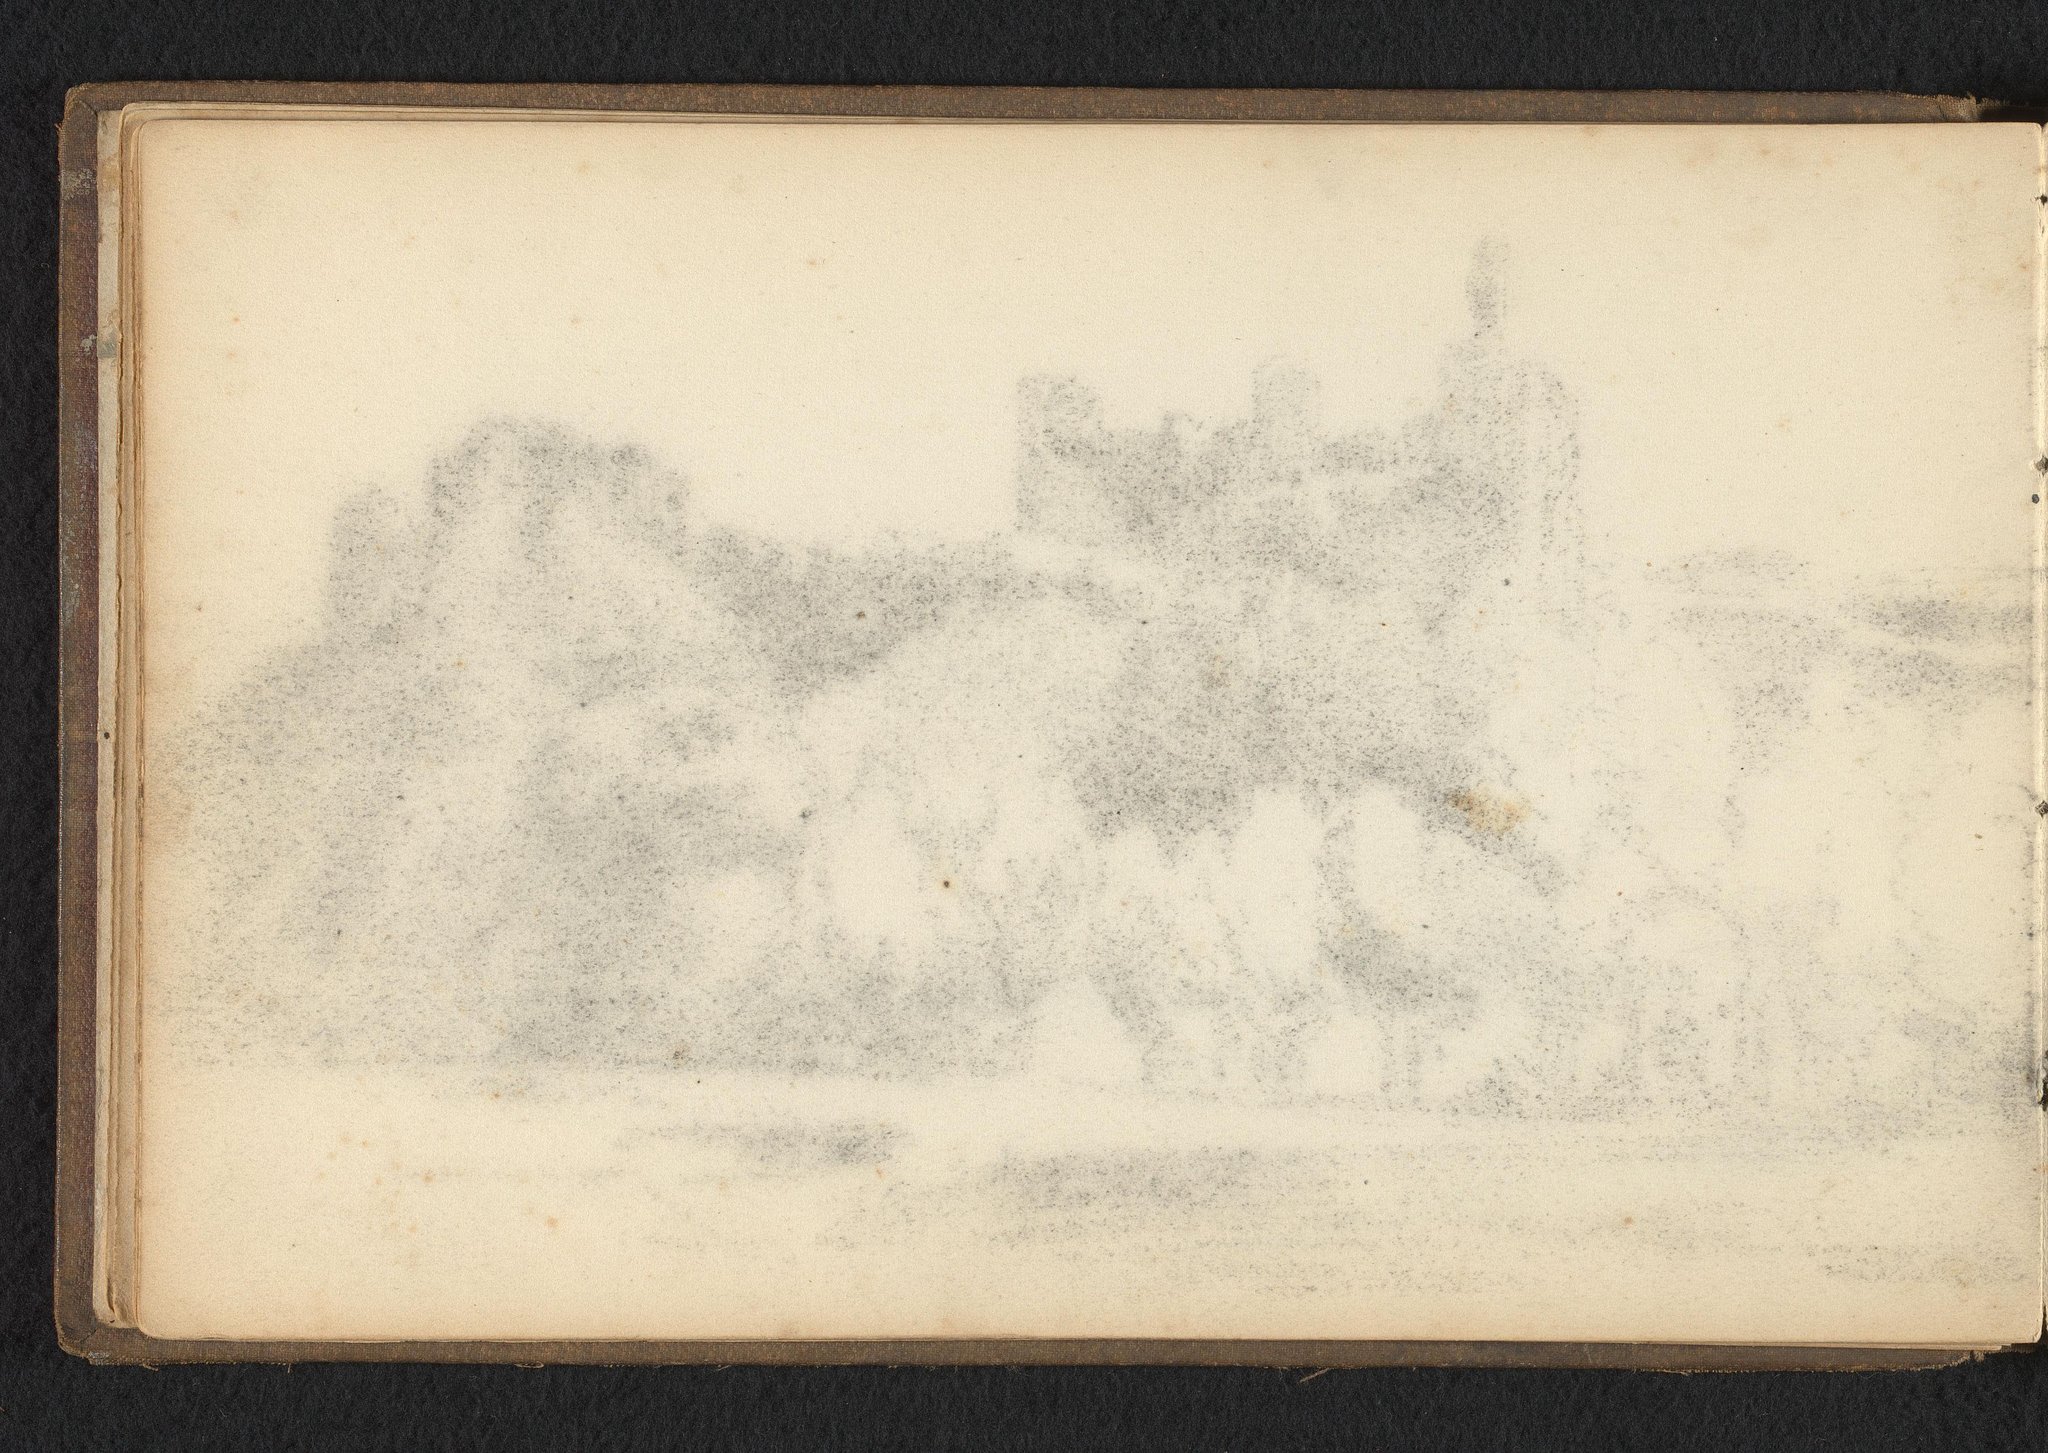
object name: sketchbook leaf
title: Abklatsch van de tekening van pagina 10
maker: jan bedijs tom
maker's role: draughtsman, painter, print maker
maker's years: 1813-1894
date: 1823-1894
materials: paper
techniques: printmaking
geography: the hague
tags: landscape with ruins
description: Pagina 9 verso uit een schetsboek met 37 bladen.